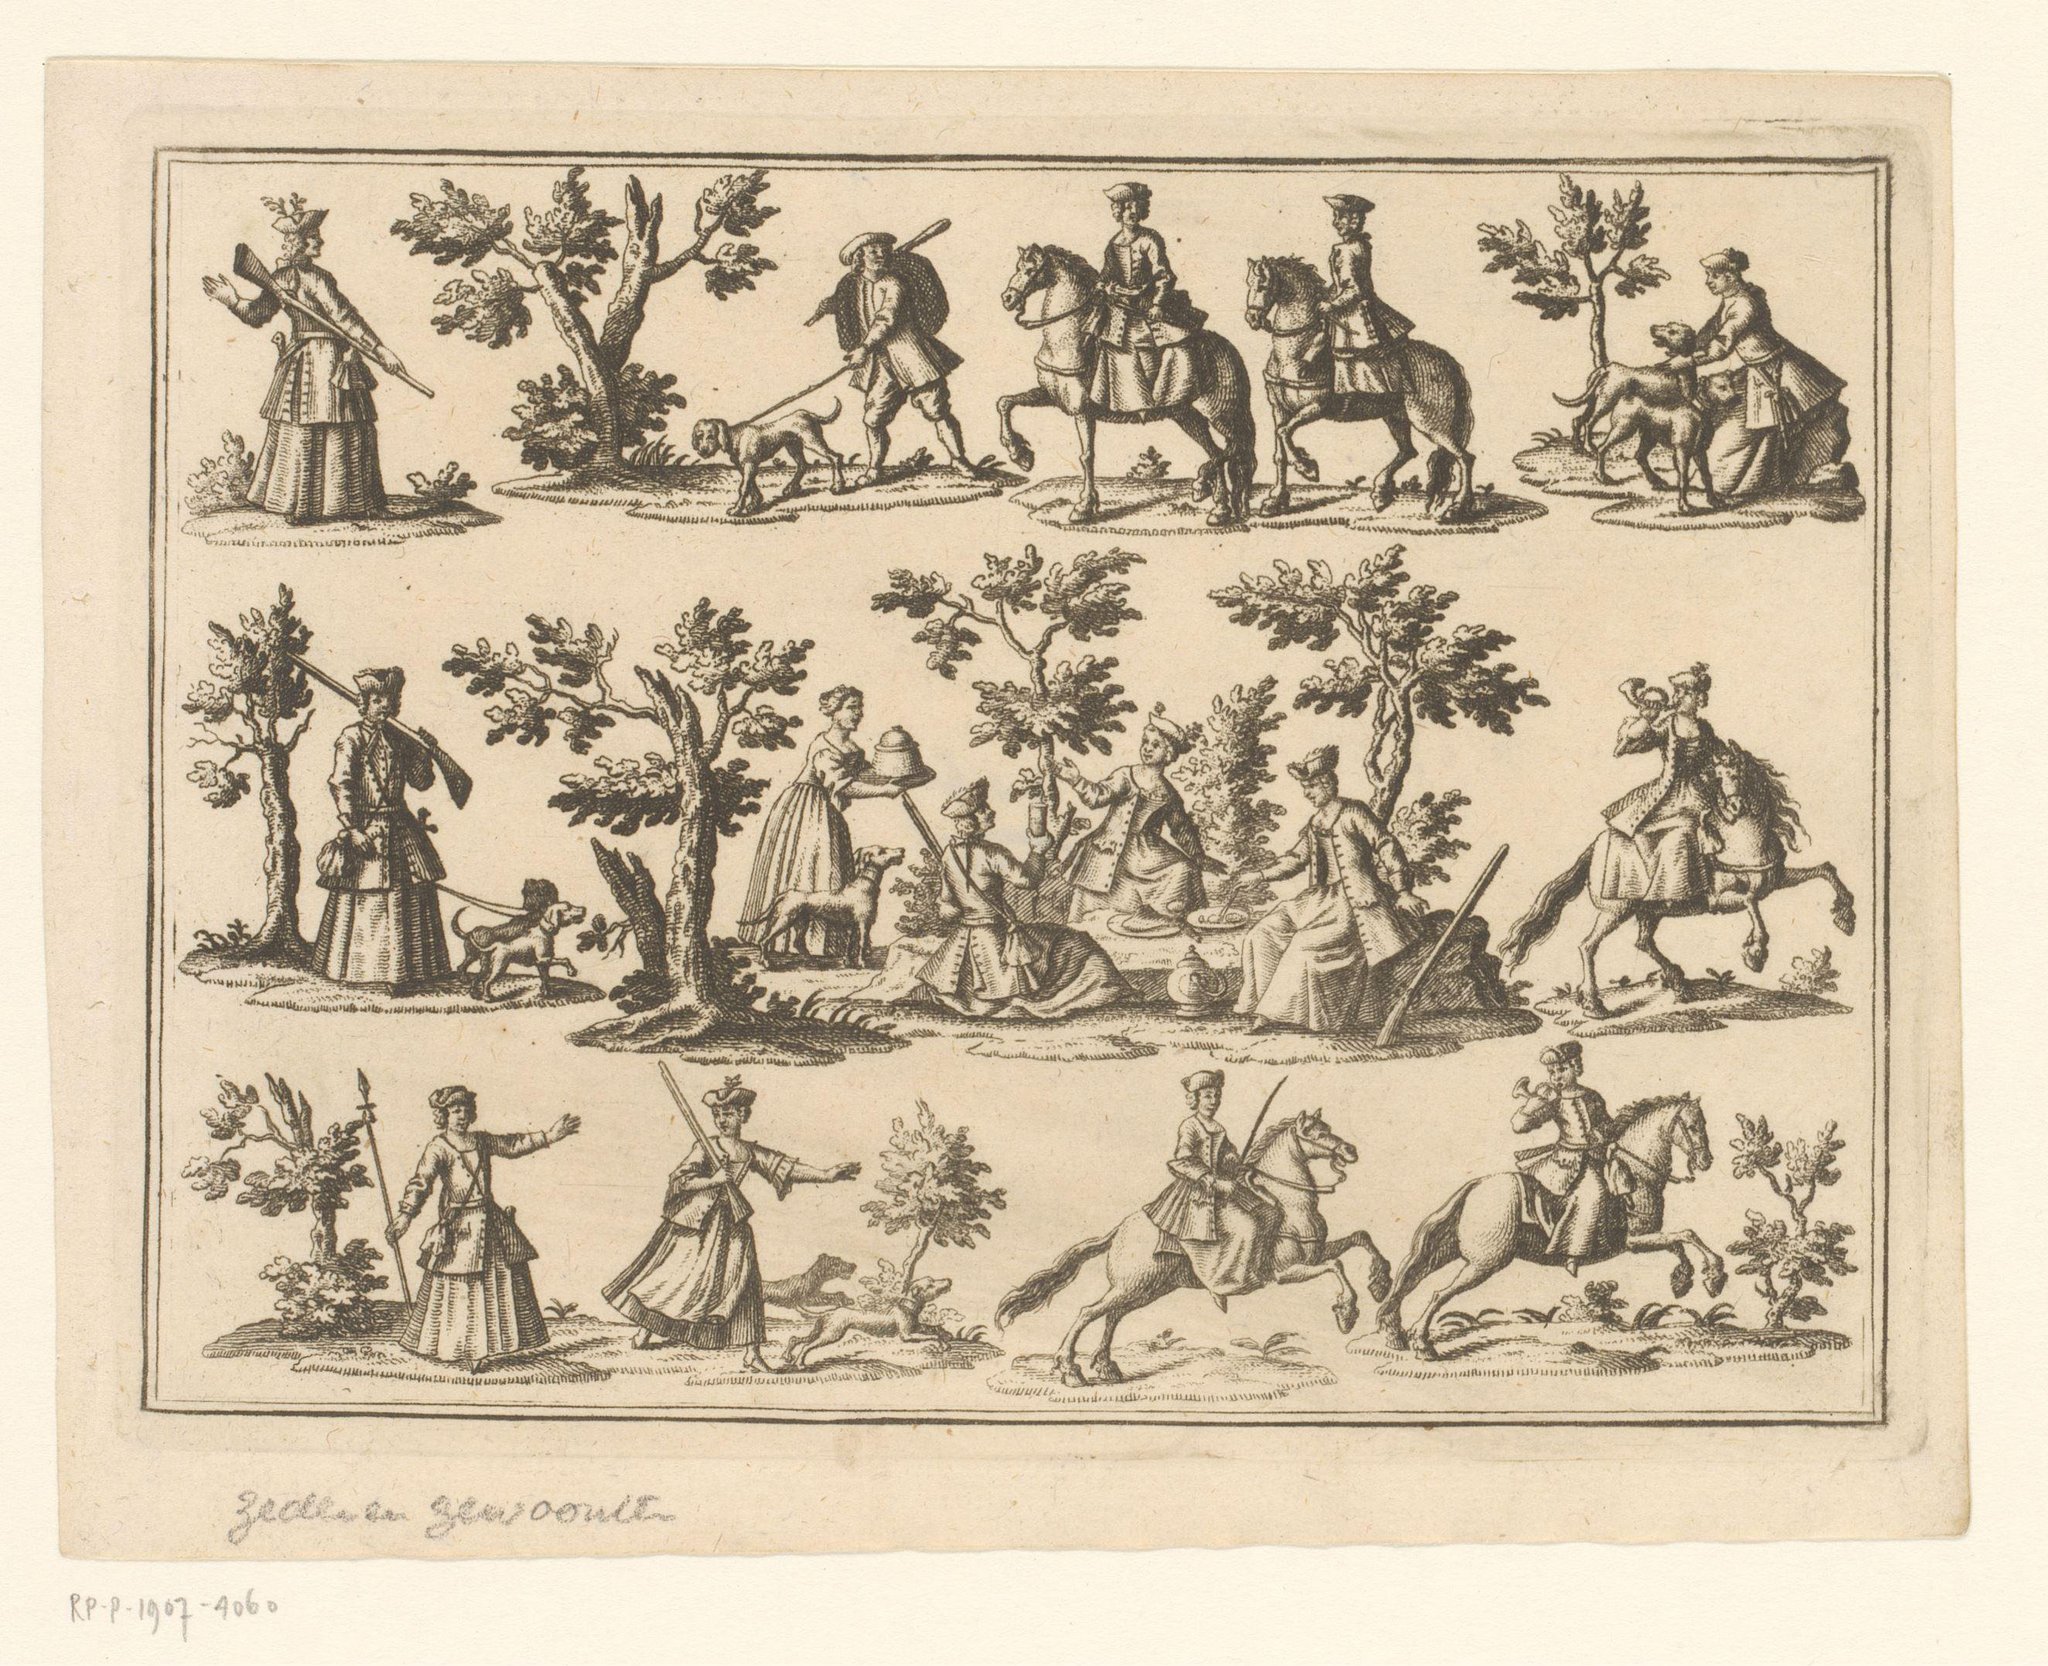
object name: print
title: Verscheyde Playsante Jagten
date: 1718-1757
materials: paper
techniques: etching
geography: amsterdam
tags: midday meal, lunch - cc - out of doors, hunting dogs, casting weapons: spear, blowing the hunting horn, firearms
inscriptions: collector's mark: Lugt 2228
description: Op de prent staan elf landschappen met jagers. Centraal een voorstelling met vier vrouwelijke jagers die een maaltijd nuttigen in de openlucht.